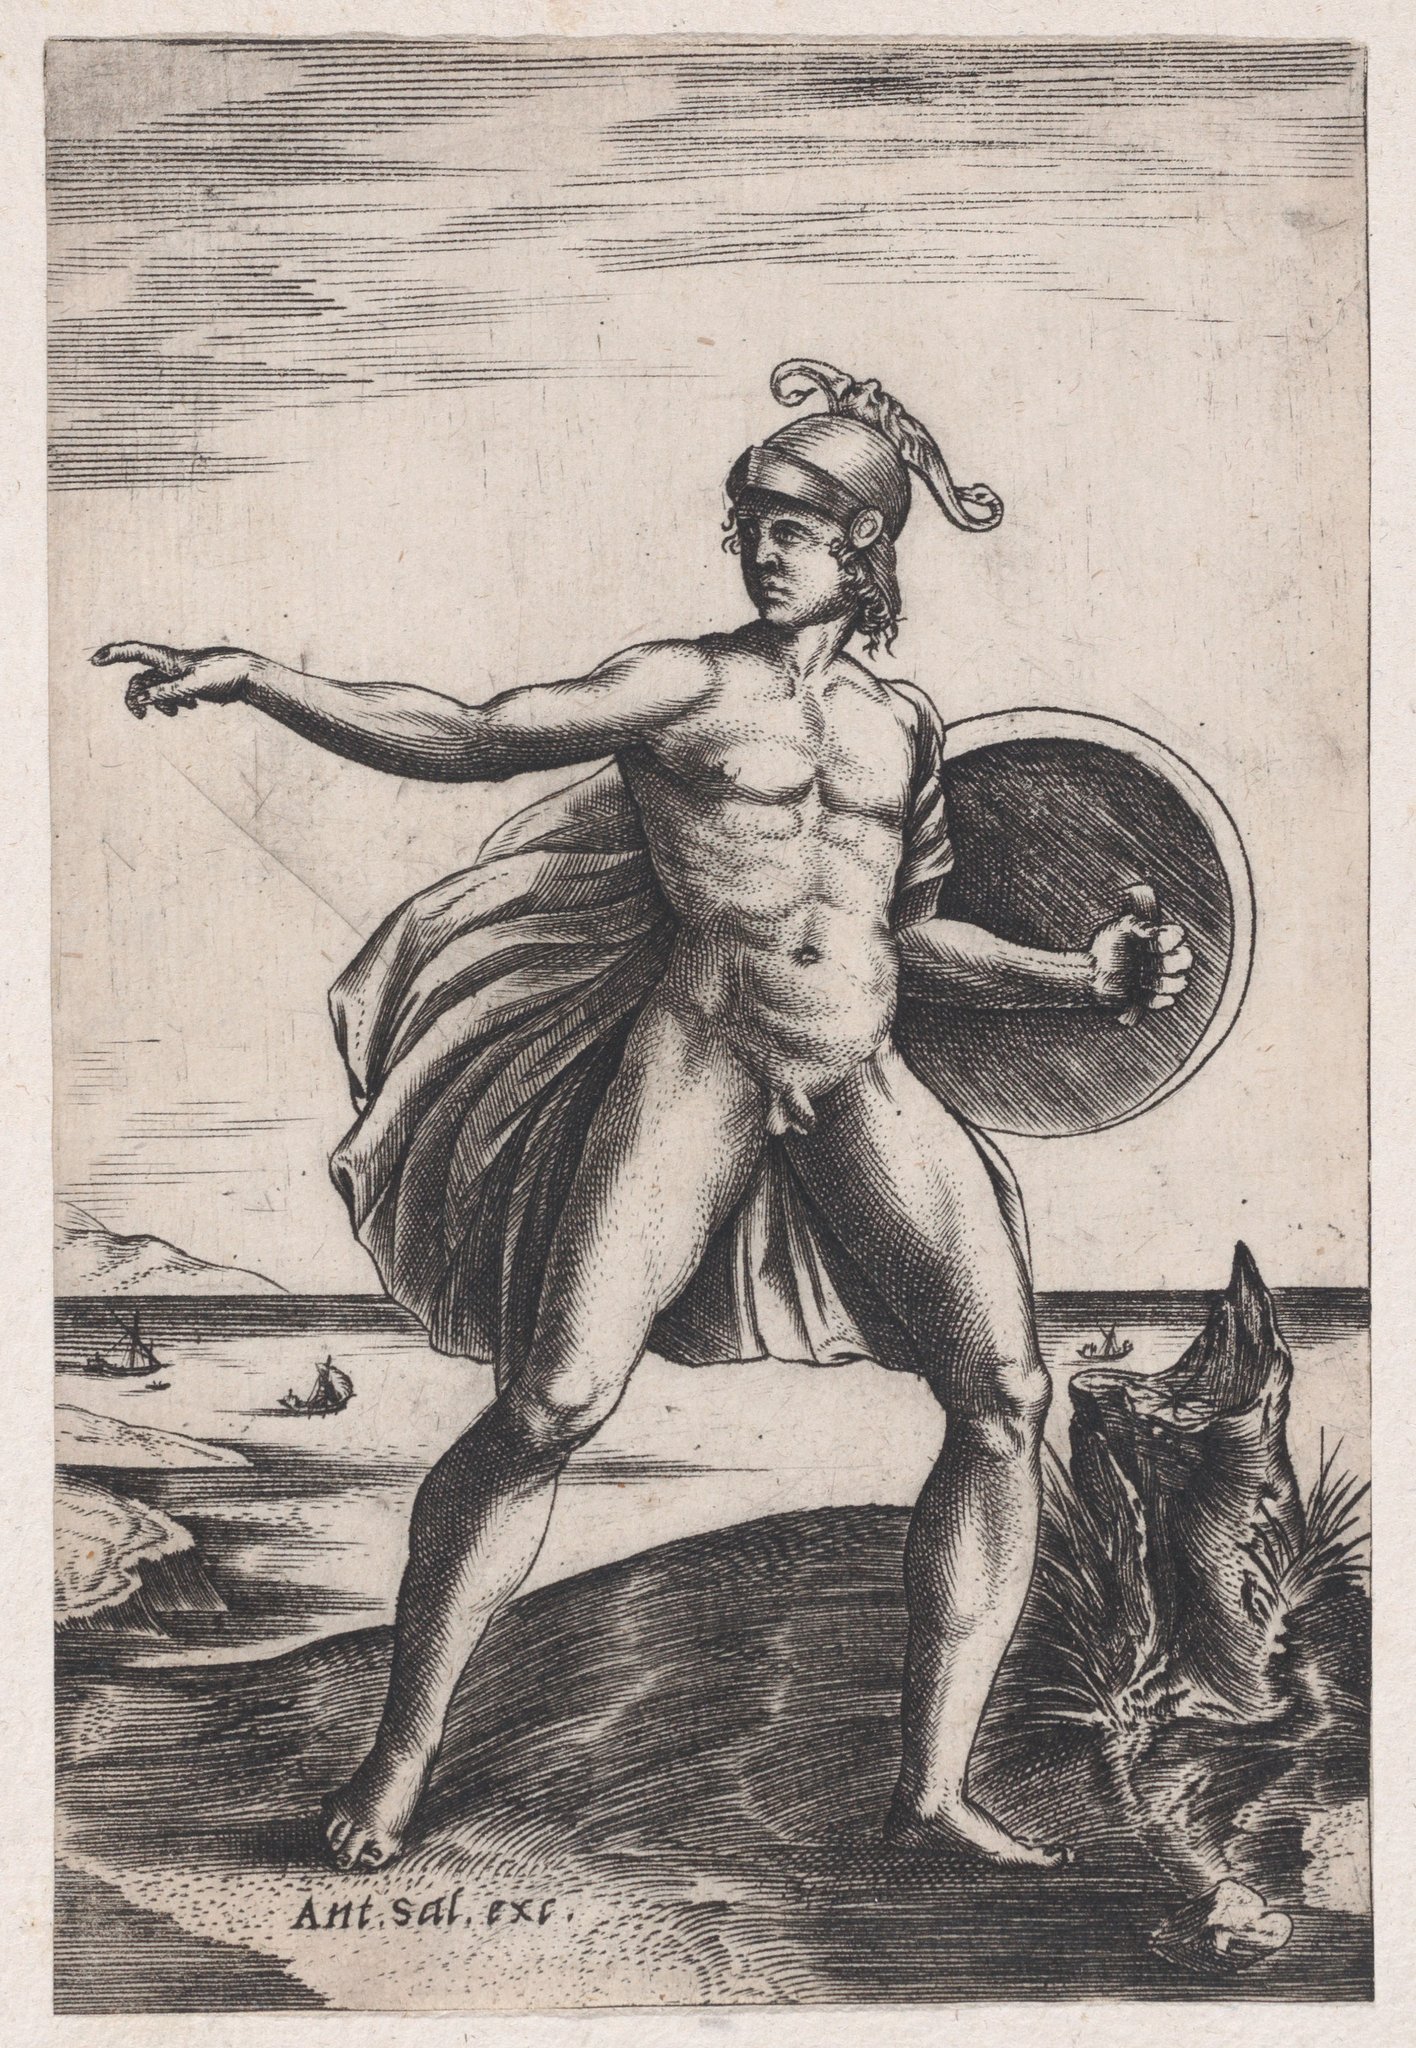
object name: print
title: A Warrior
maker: agostino veneziano (agostino dei musi)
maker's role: artist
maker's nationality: italian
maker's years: 1490-1536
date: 1514-1536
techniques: engraving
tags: male nudes,warriors